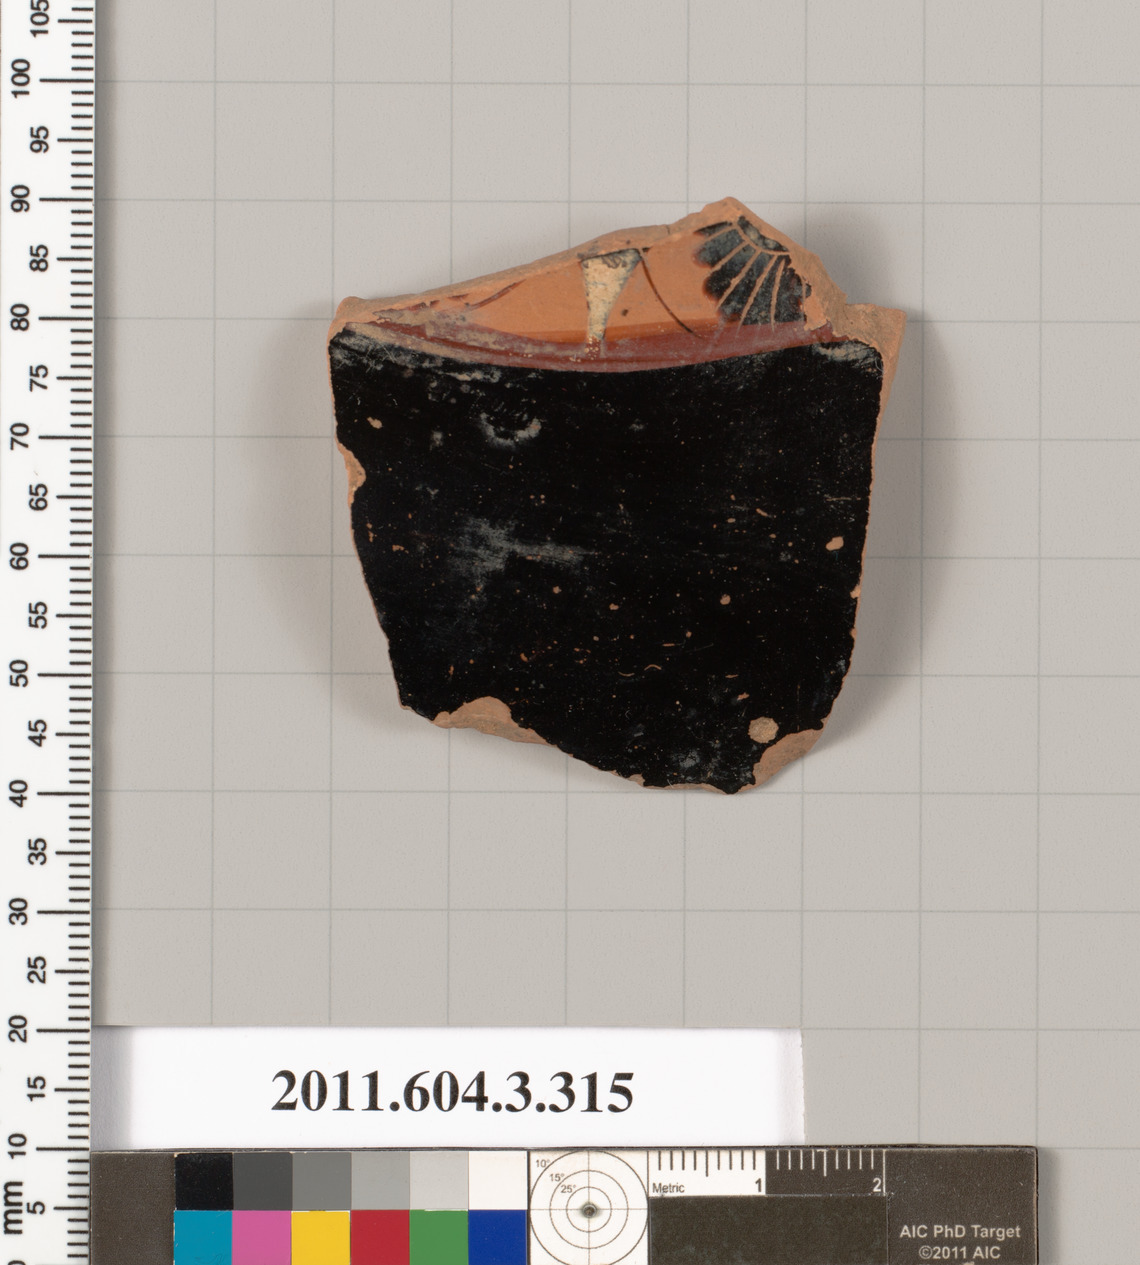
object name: neck amphora fragment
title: Terracotta fragment of an neck-amphora (jar)?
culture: greek, attic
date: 550-526 BCE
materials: terracotta